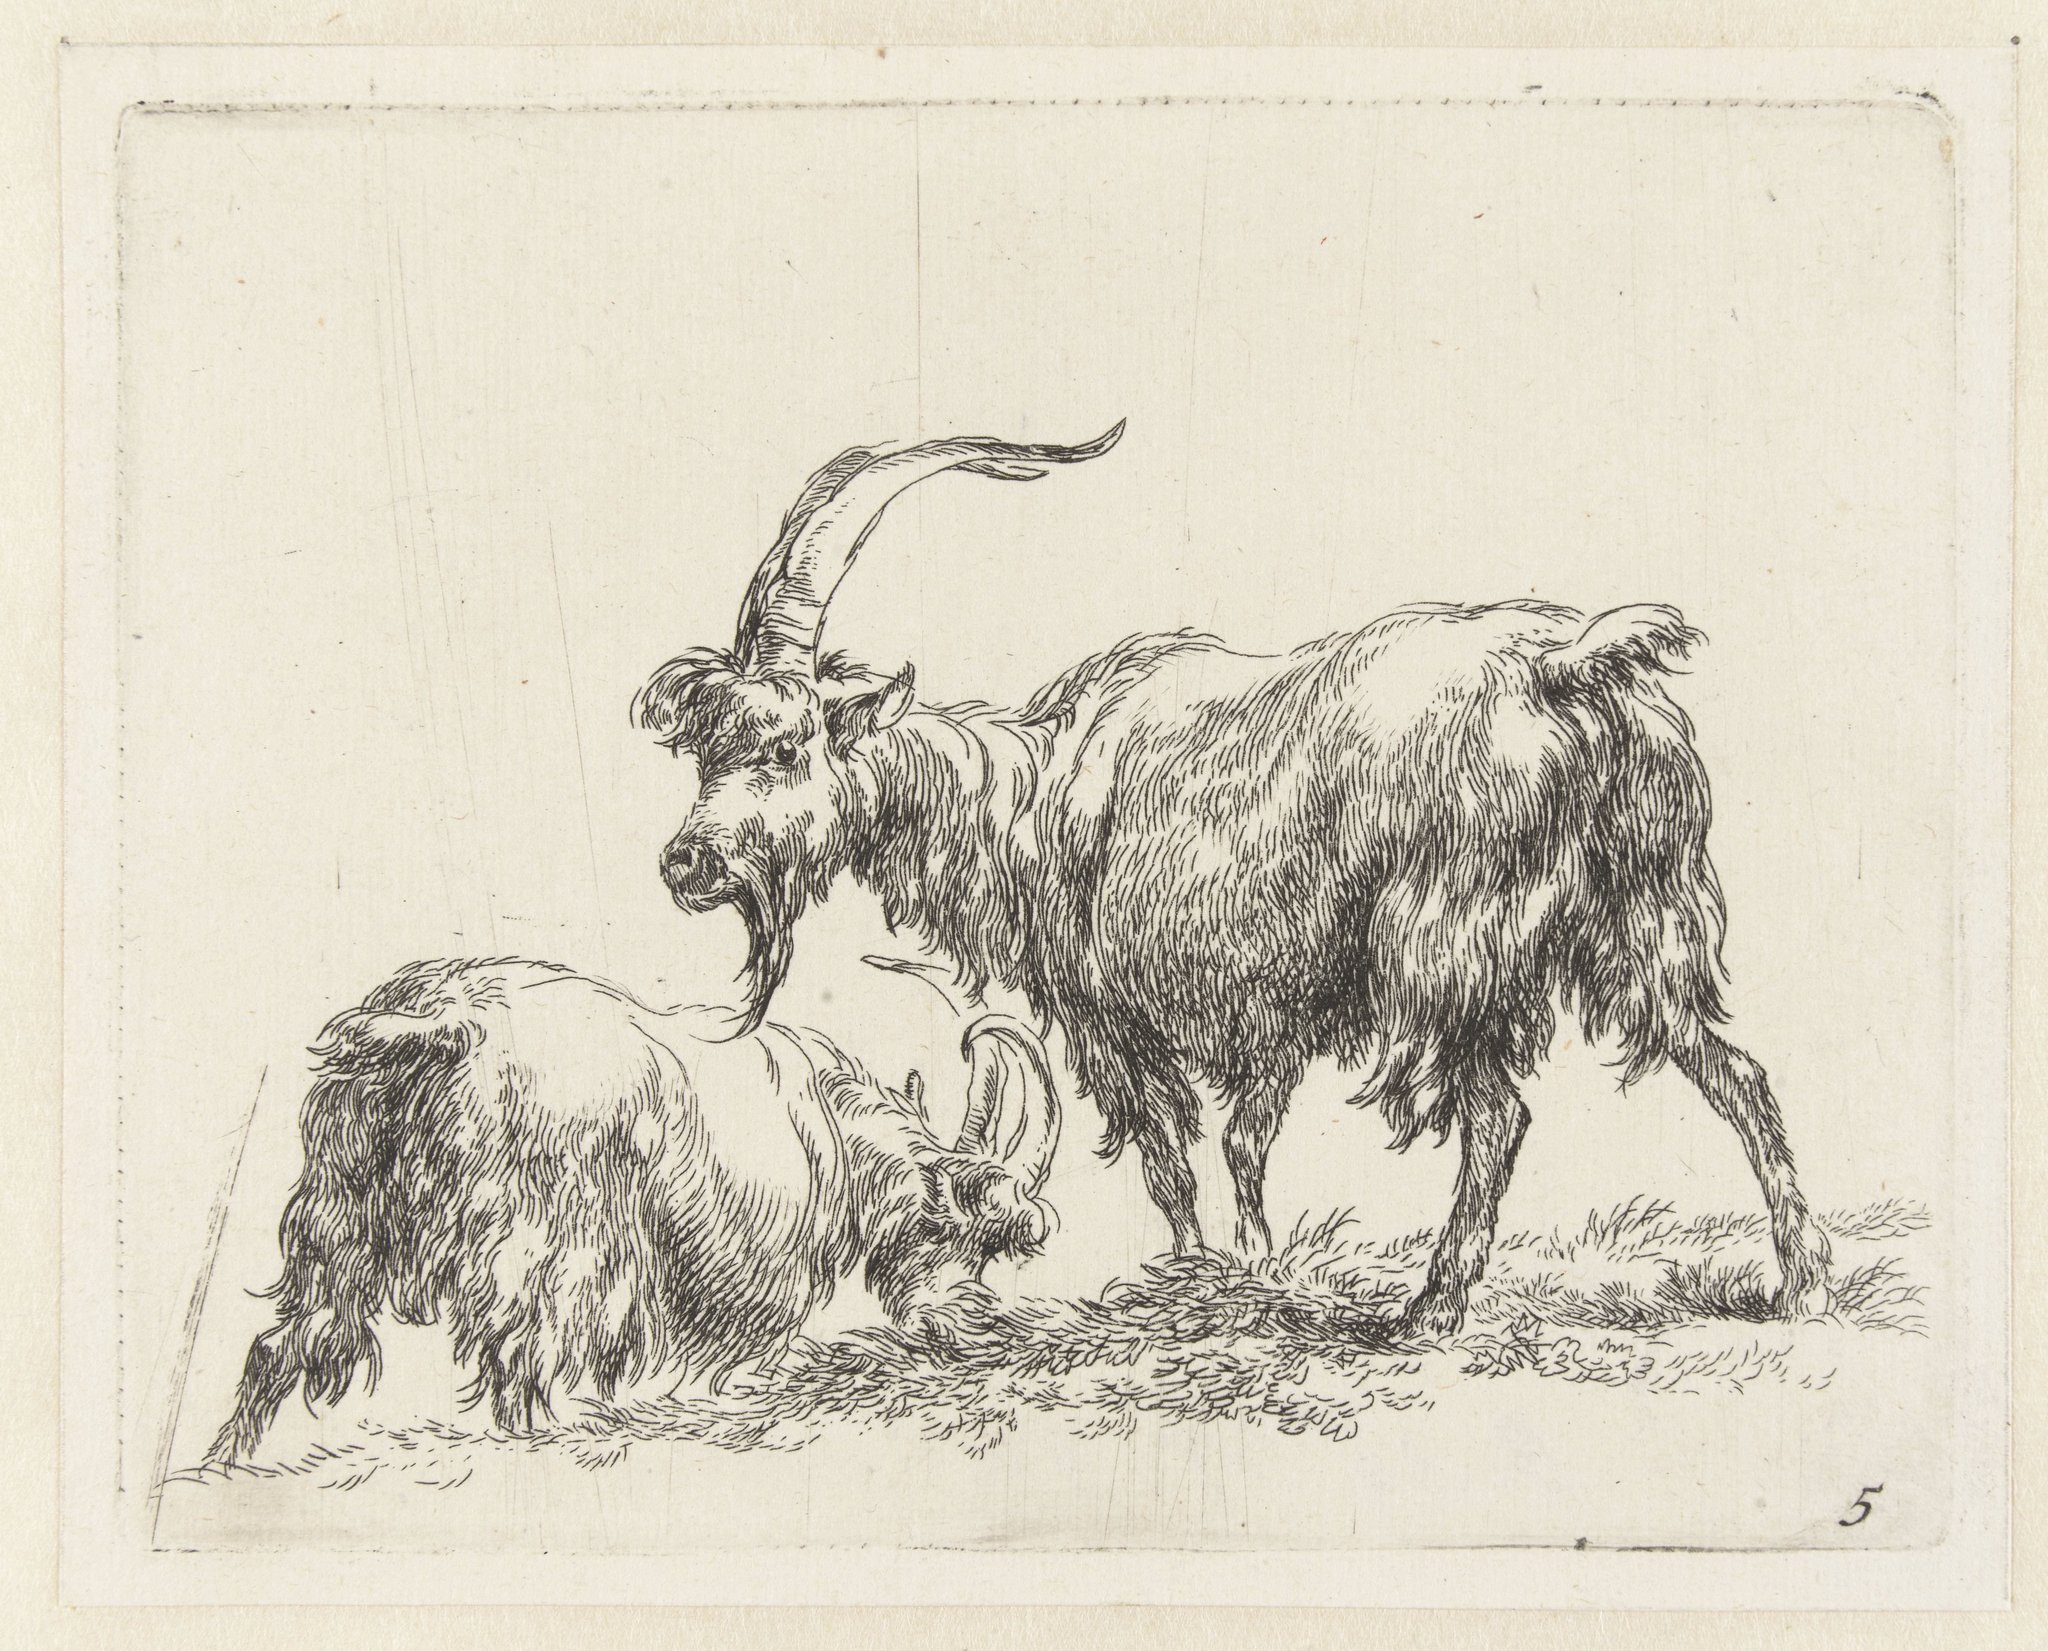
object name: print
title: Geiten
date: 1648-1652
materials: paper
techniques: etching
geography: netherlands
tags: goat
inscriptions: collector's mark: Lugt 240